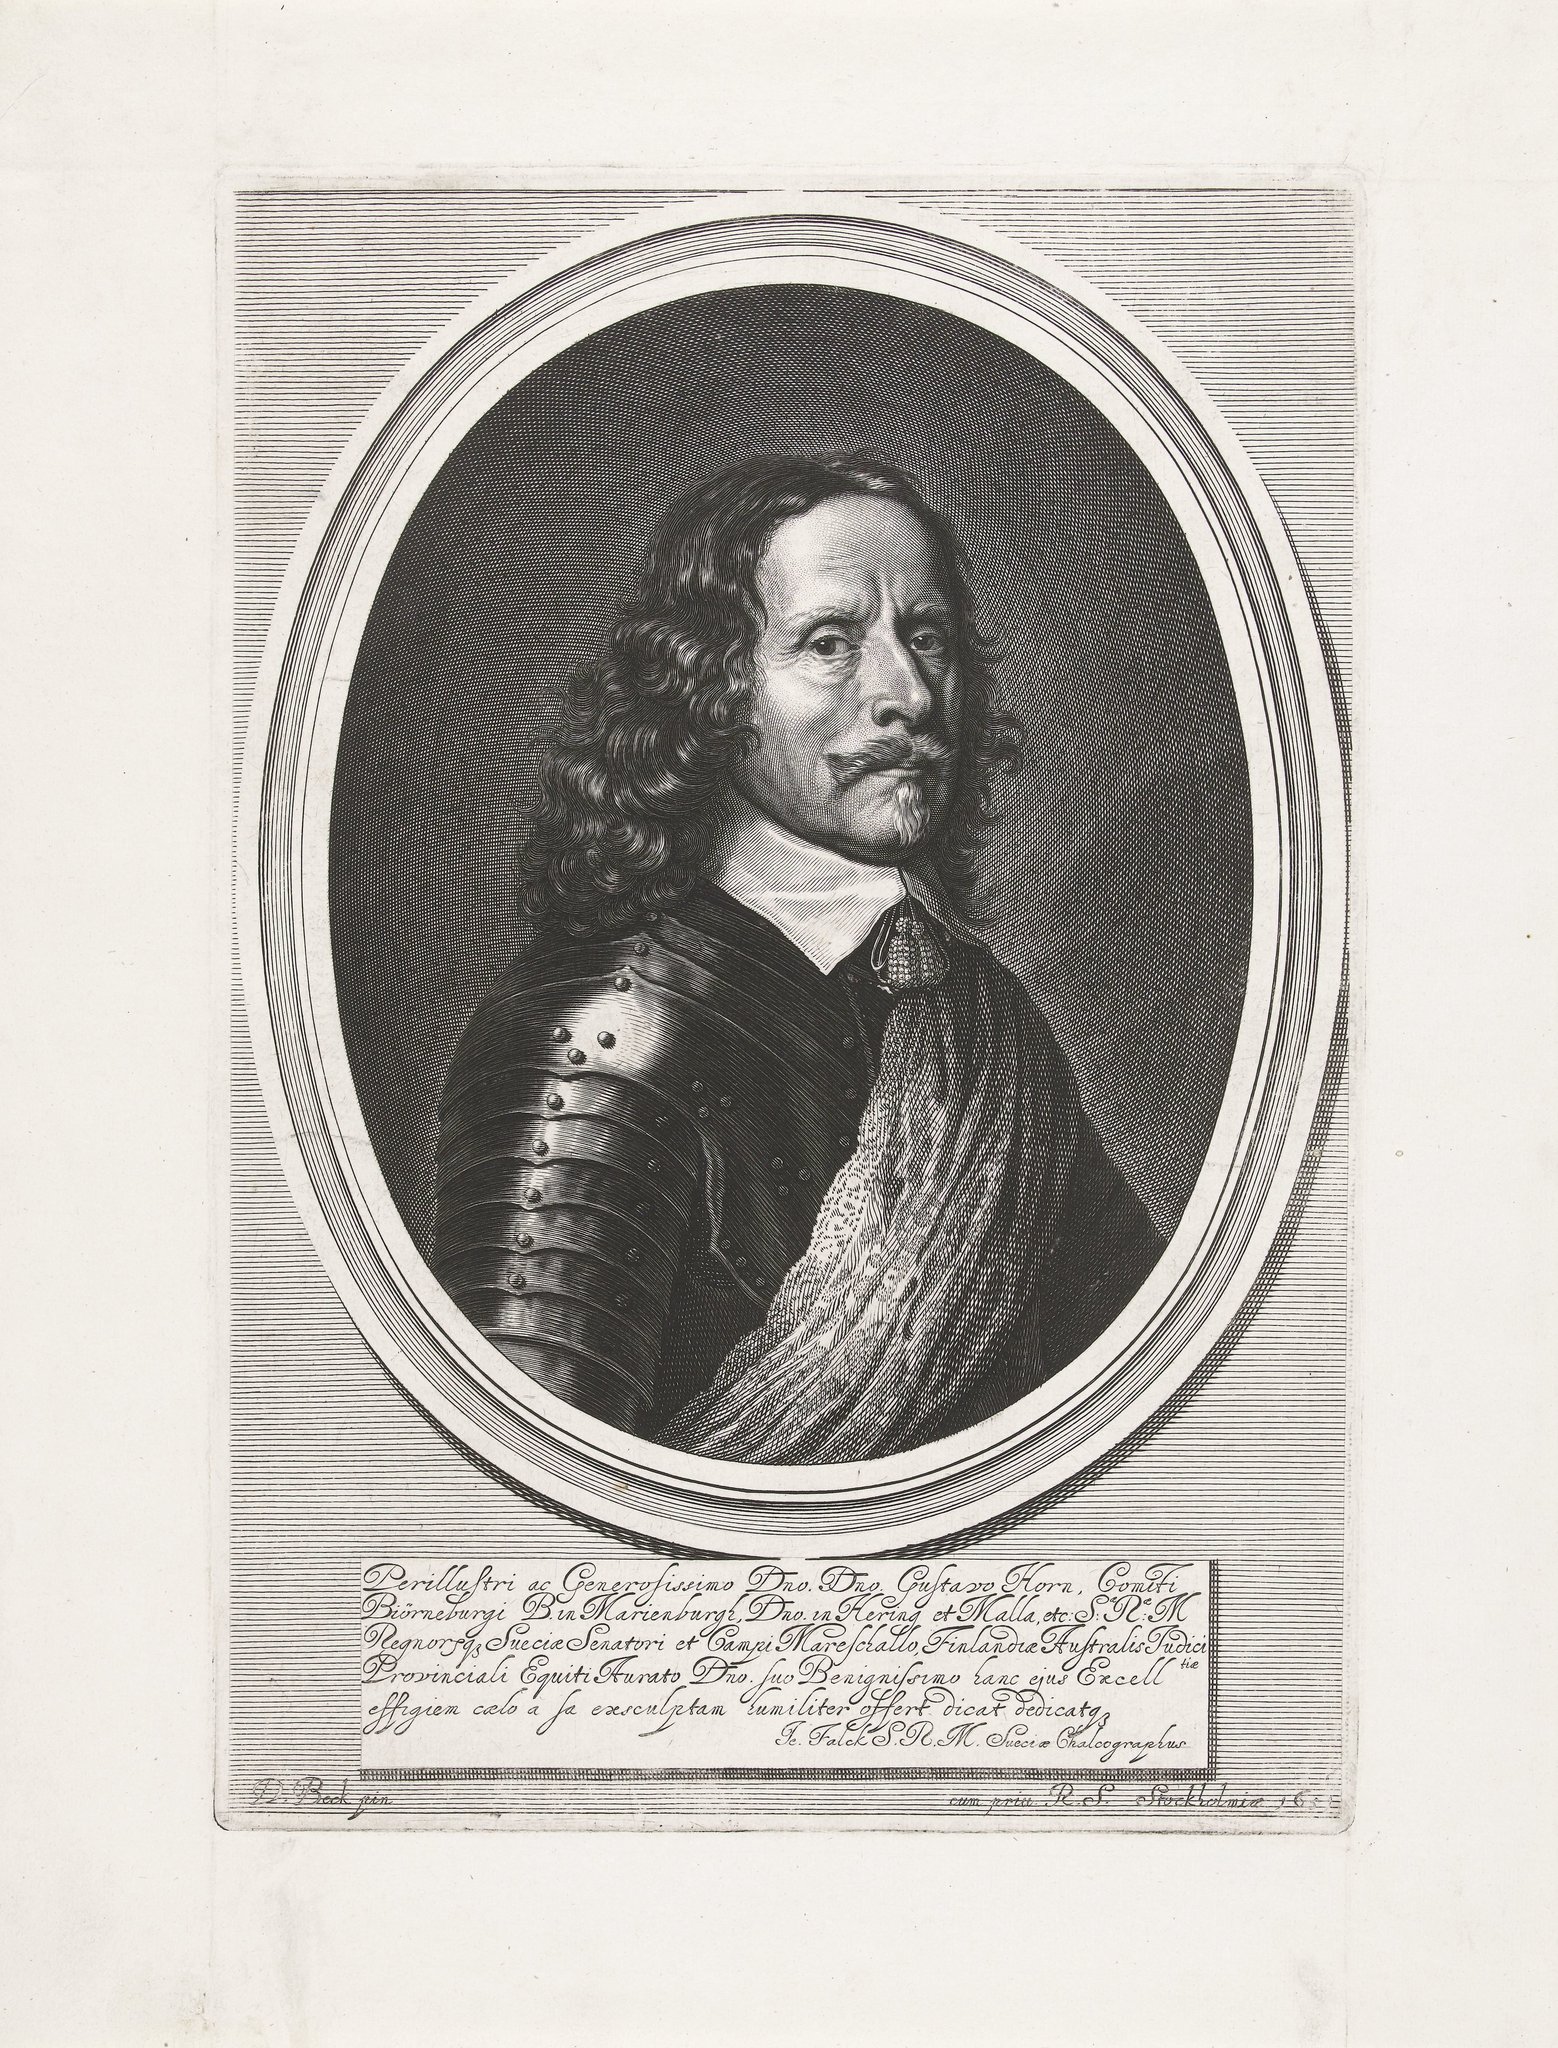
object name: print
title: Portret van Gustav Horn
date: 1651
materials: paper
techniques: engraving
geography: stockholm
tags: generaal, gustav horn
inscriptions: collector's mark: Lugt 240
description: Portret van de Zweedse generaal Gustav Horn, ten halven lijve afgebeeld in harnas met sjerp. In een ovale omlijsting met onderschrift in Latijn.